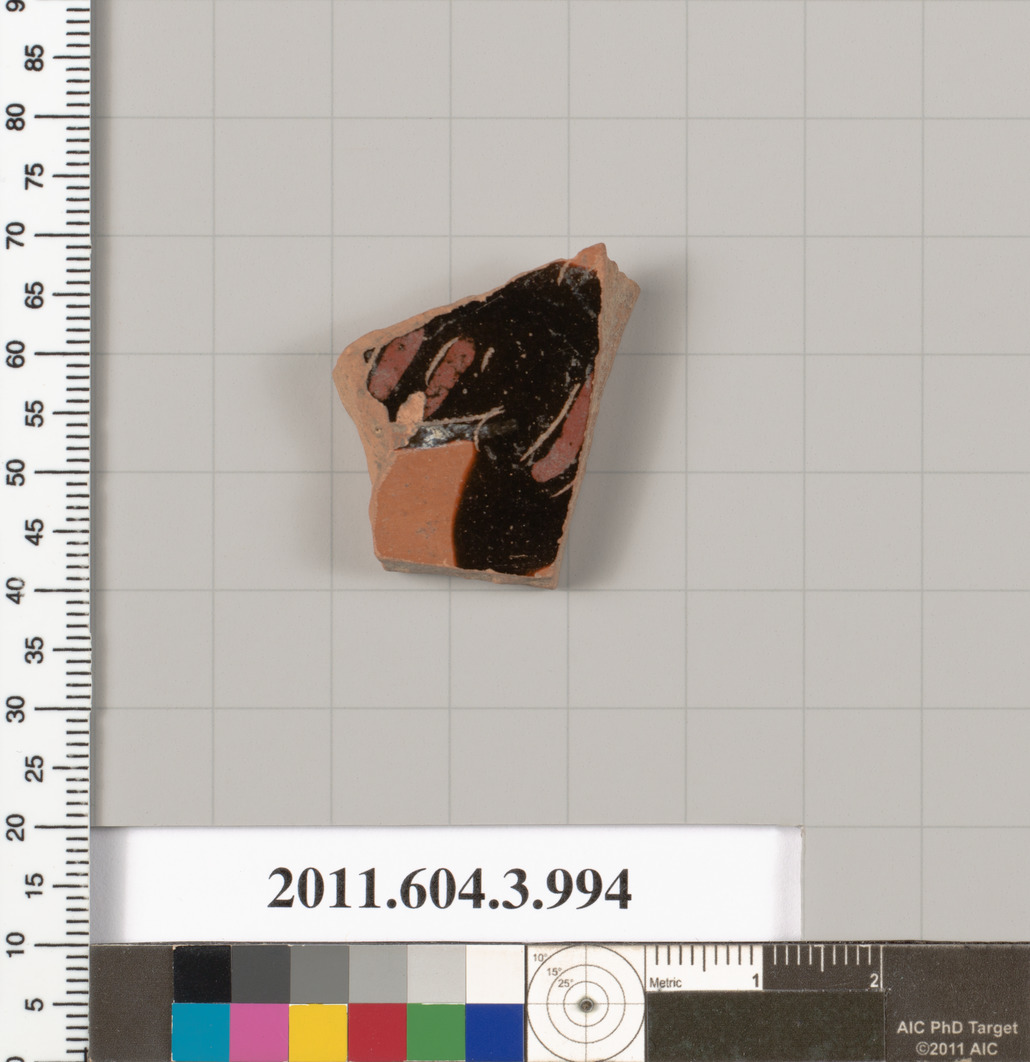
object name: lekanis lid fragment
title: Terracotta fragment of a lekanis lid (covered dish)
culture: greek, attic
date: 575-551 BCE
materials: terracotta